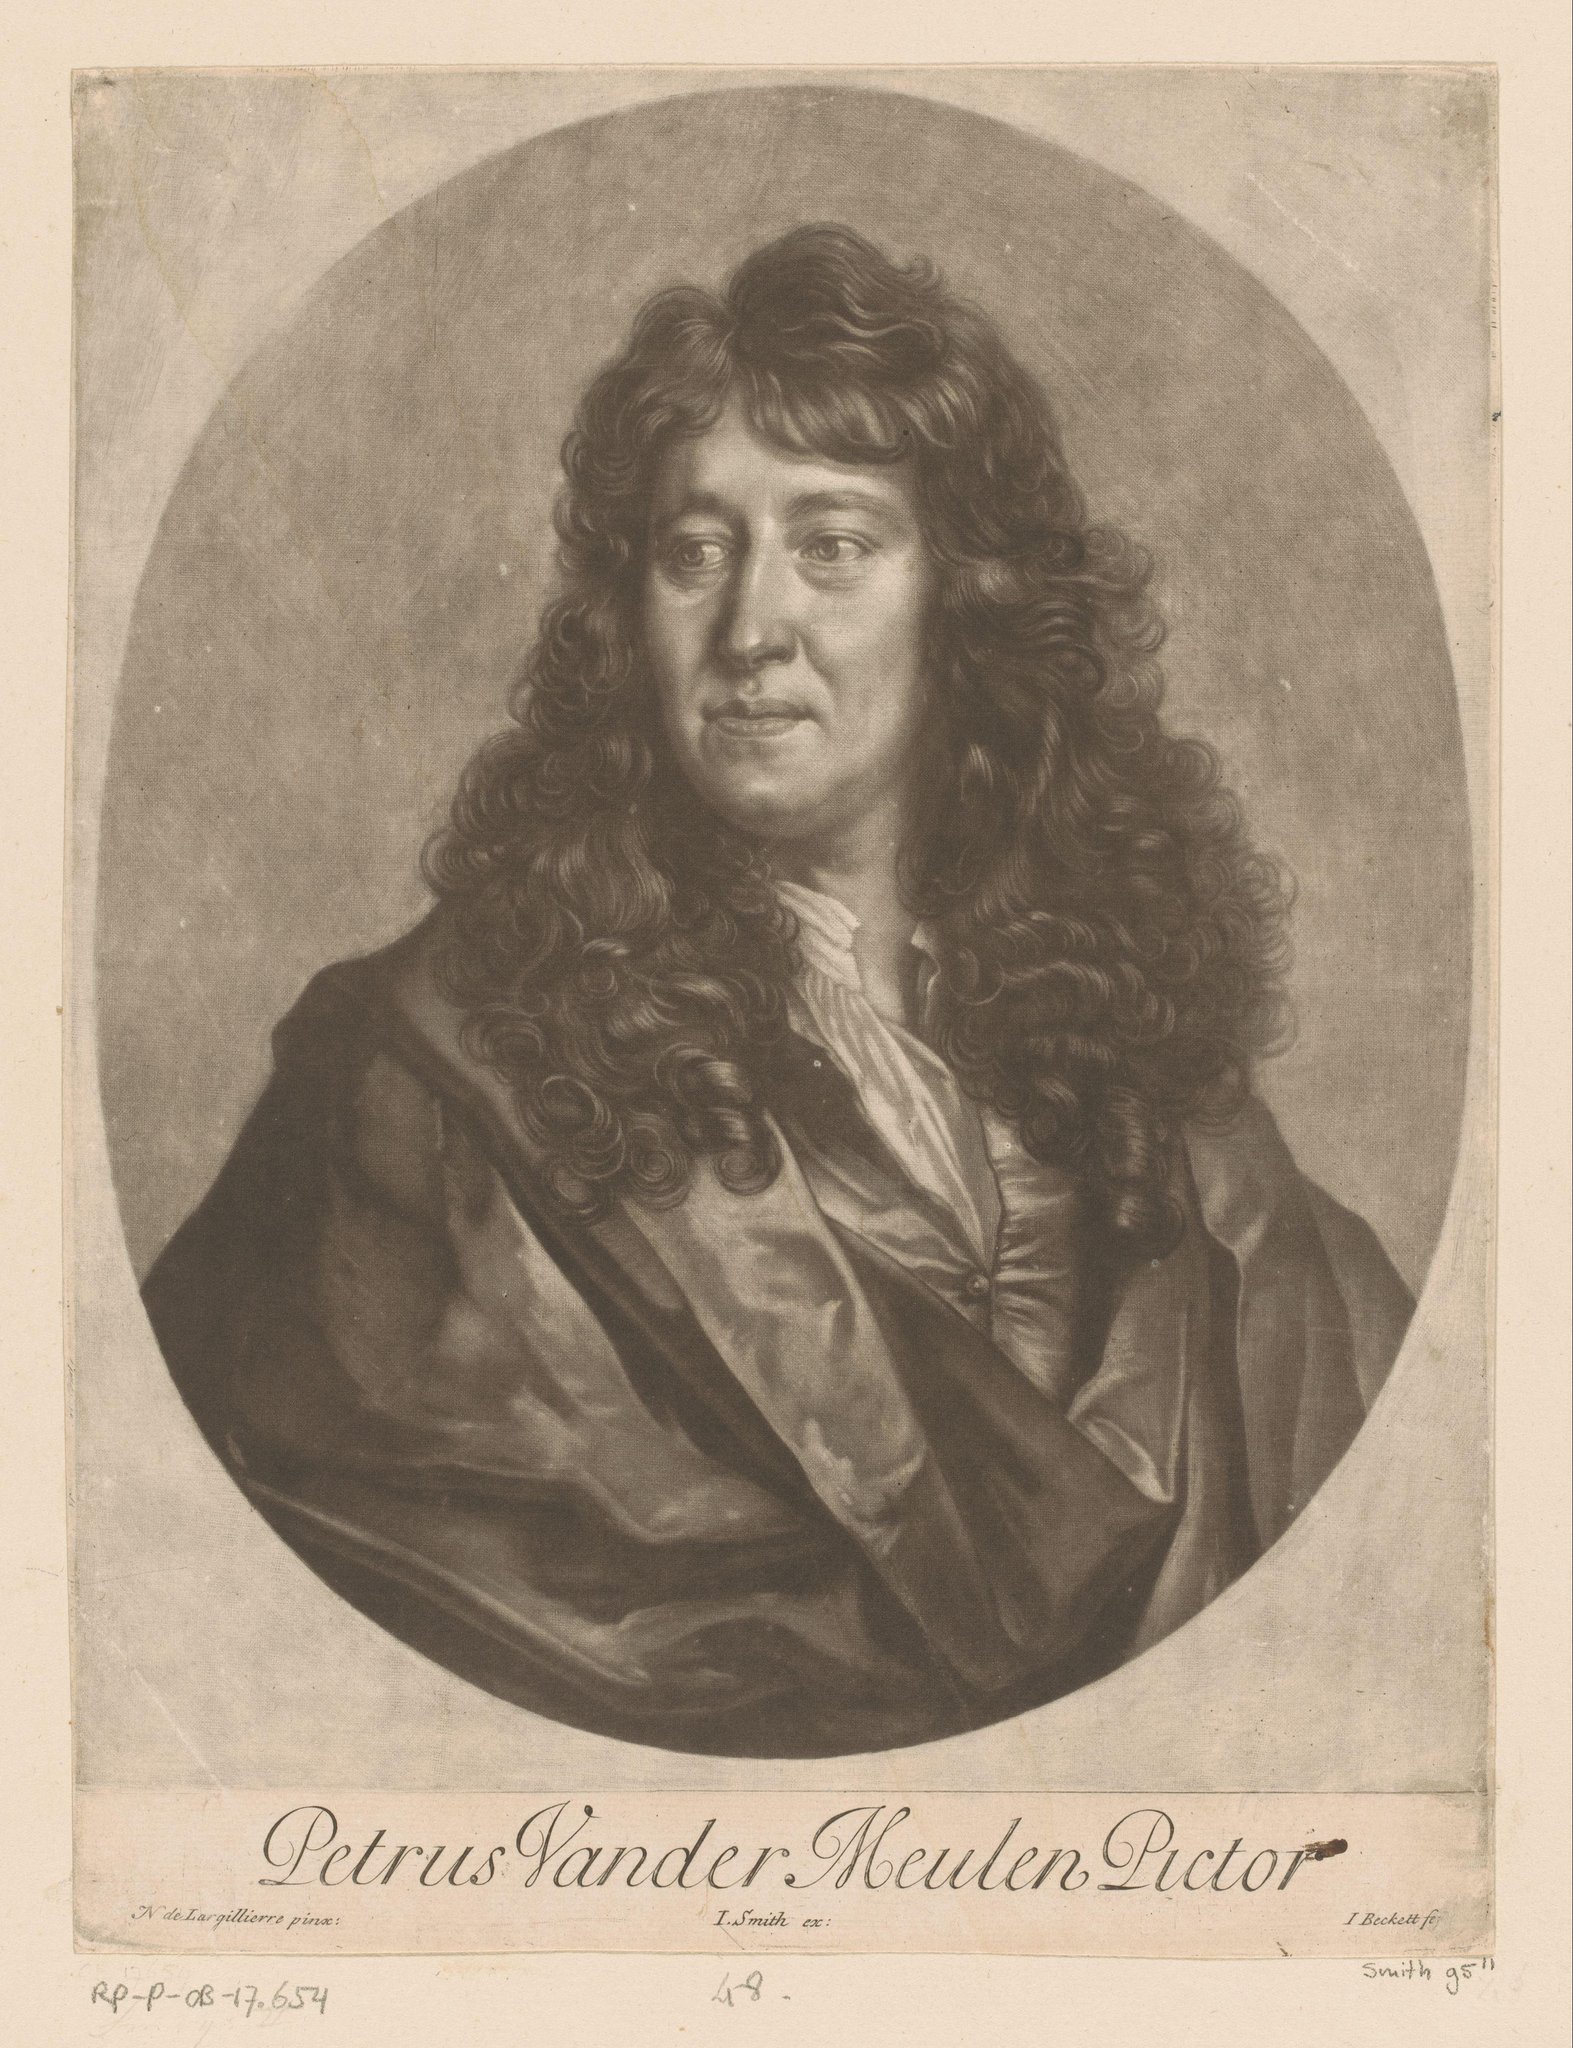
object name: print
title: Portret van Pieter van der Meulen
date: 1683-1688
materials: paper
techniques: mezzotint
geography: london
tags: painter, draughtsman, sculptor, pieter van der meulen (1638-), historical persons, portrait, self-portrait of artist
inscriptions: collector's mark: Lugt 240